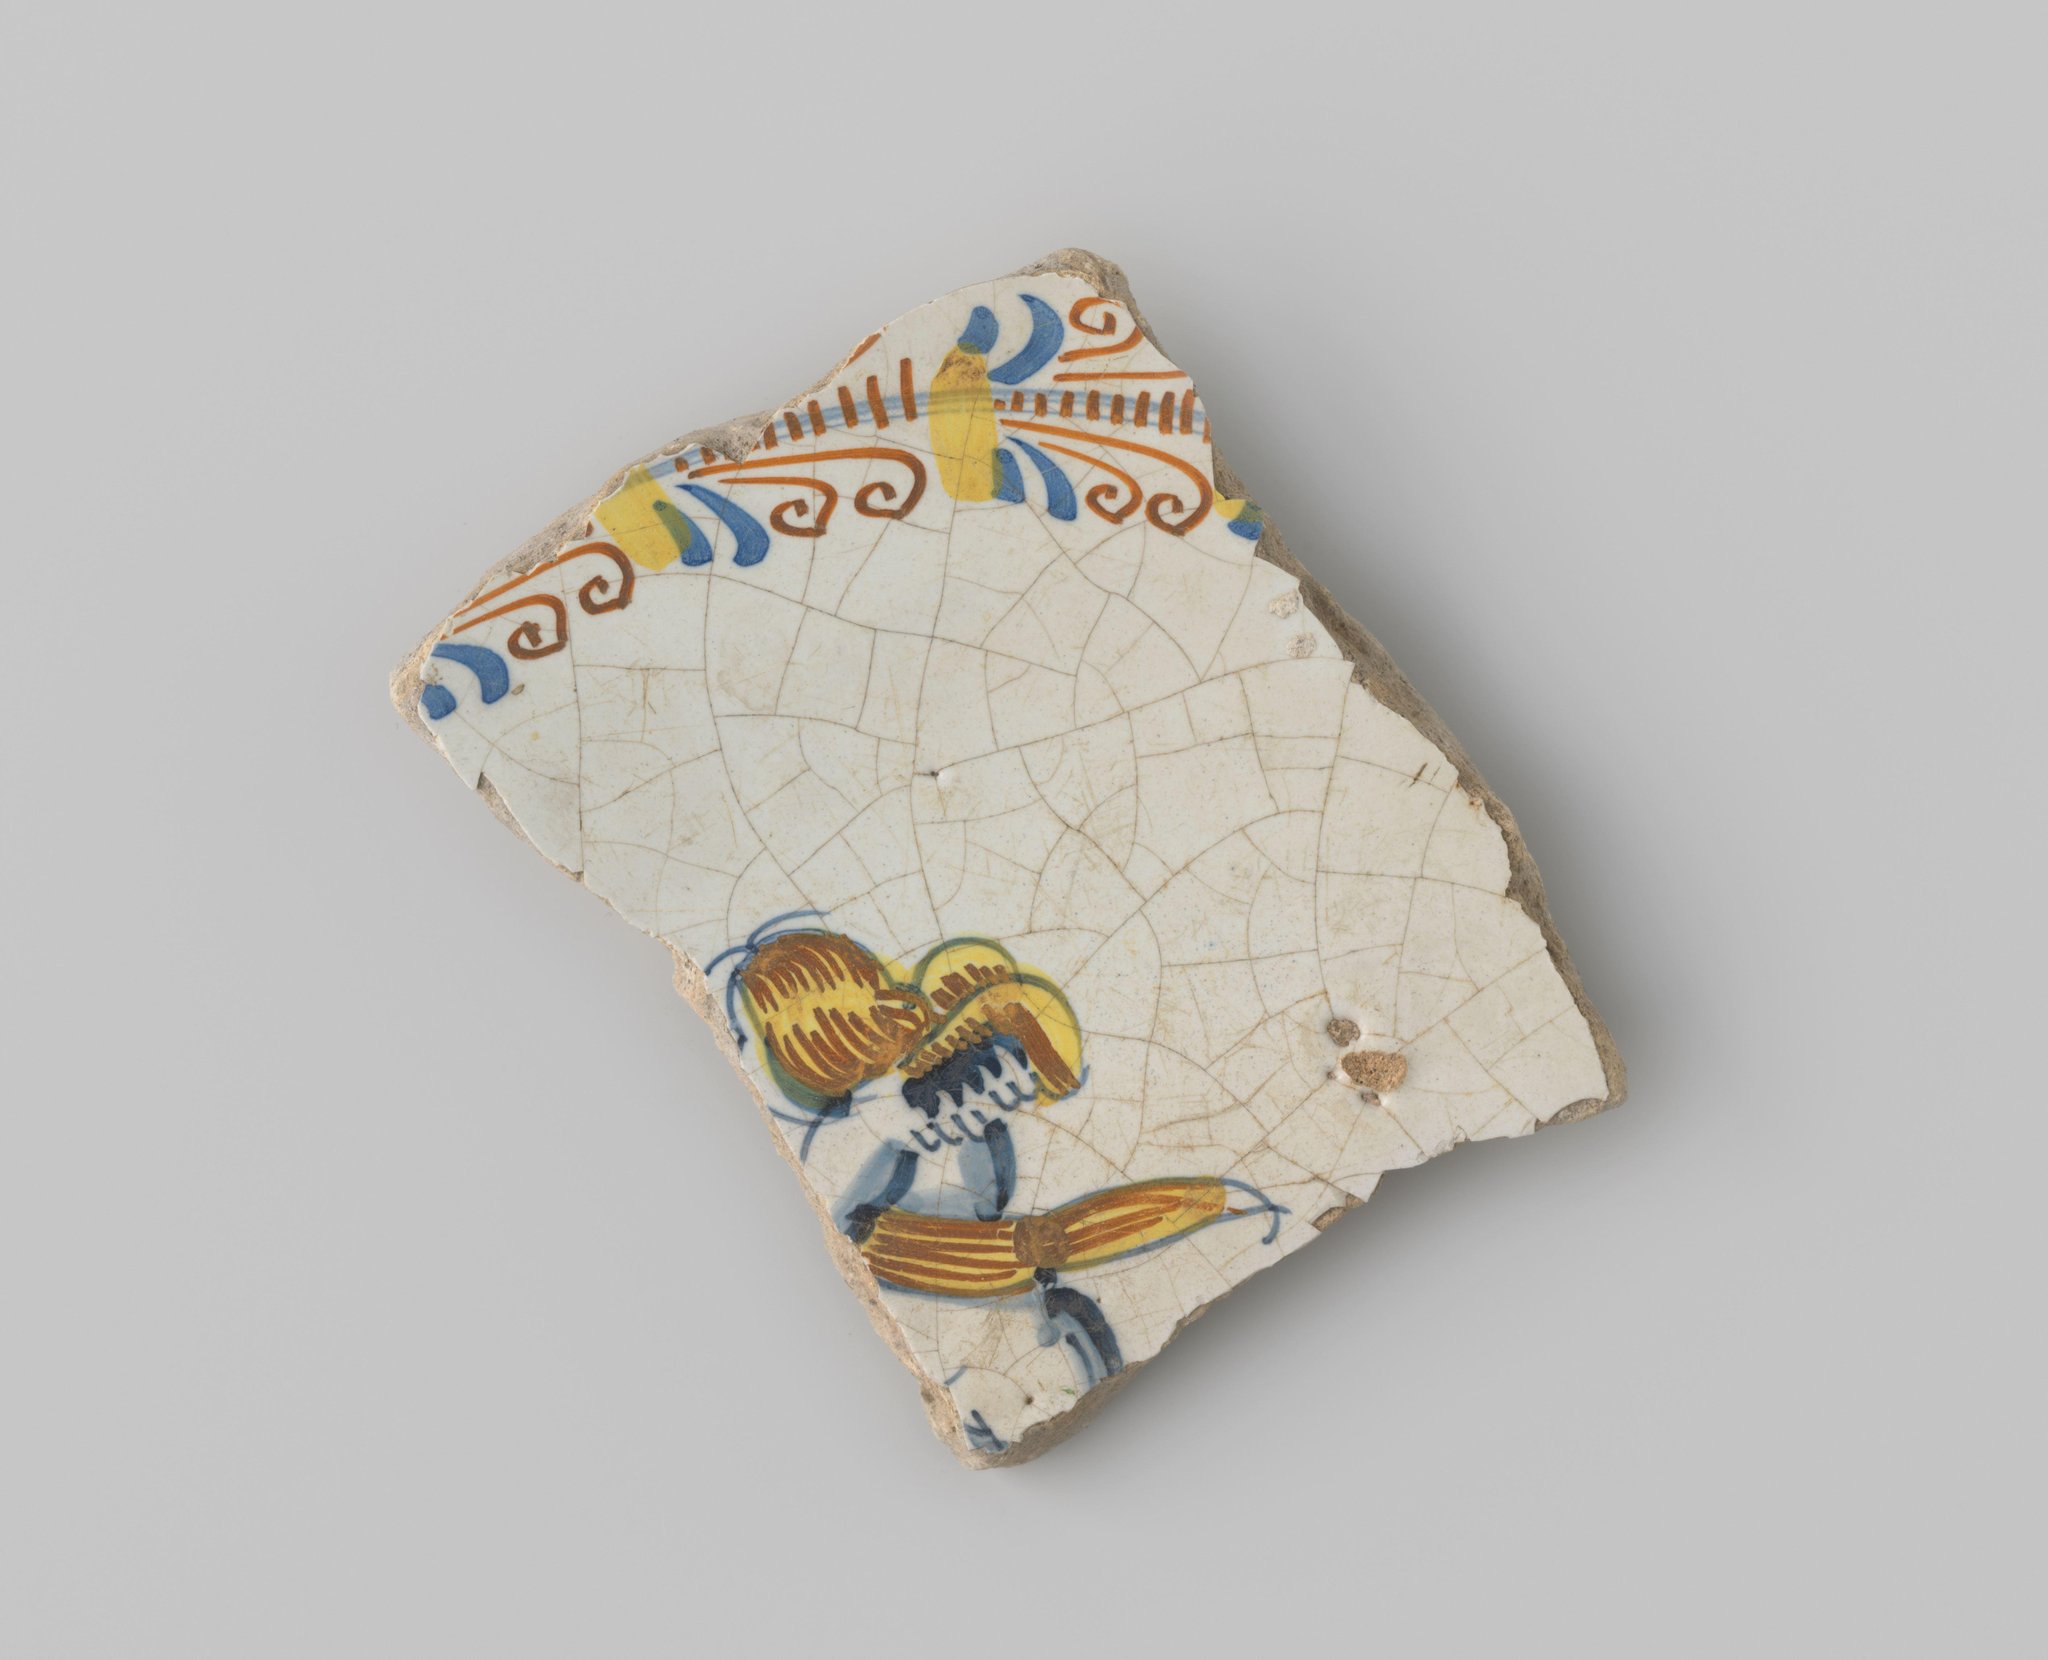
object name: fragment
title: Scherf van witbakkend aardewerk,aan de bovenzijde voorzien van een beschildering van een putto binnen een bladerkrans in blauw, geel en oranje op een witte ondergrond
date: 1500-1899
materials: earthenware, glaze